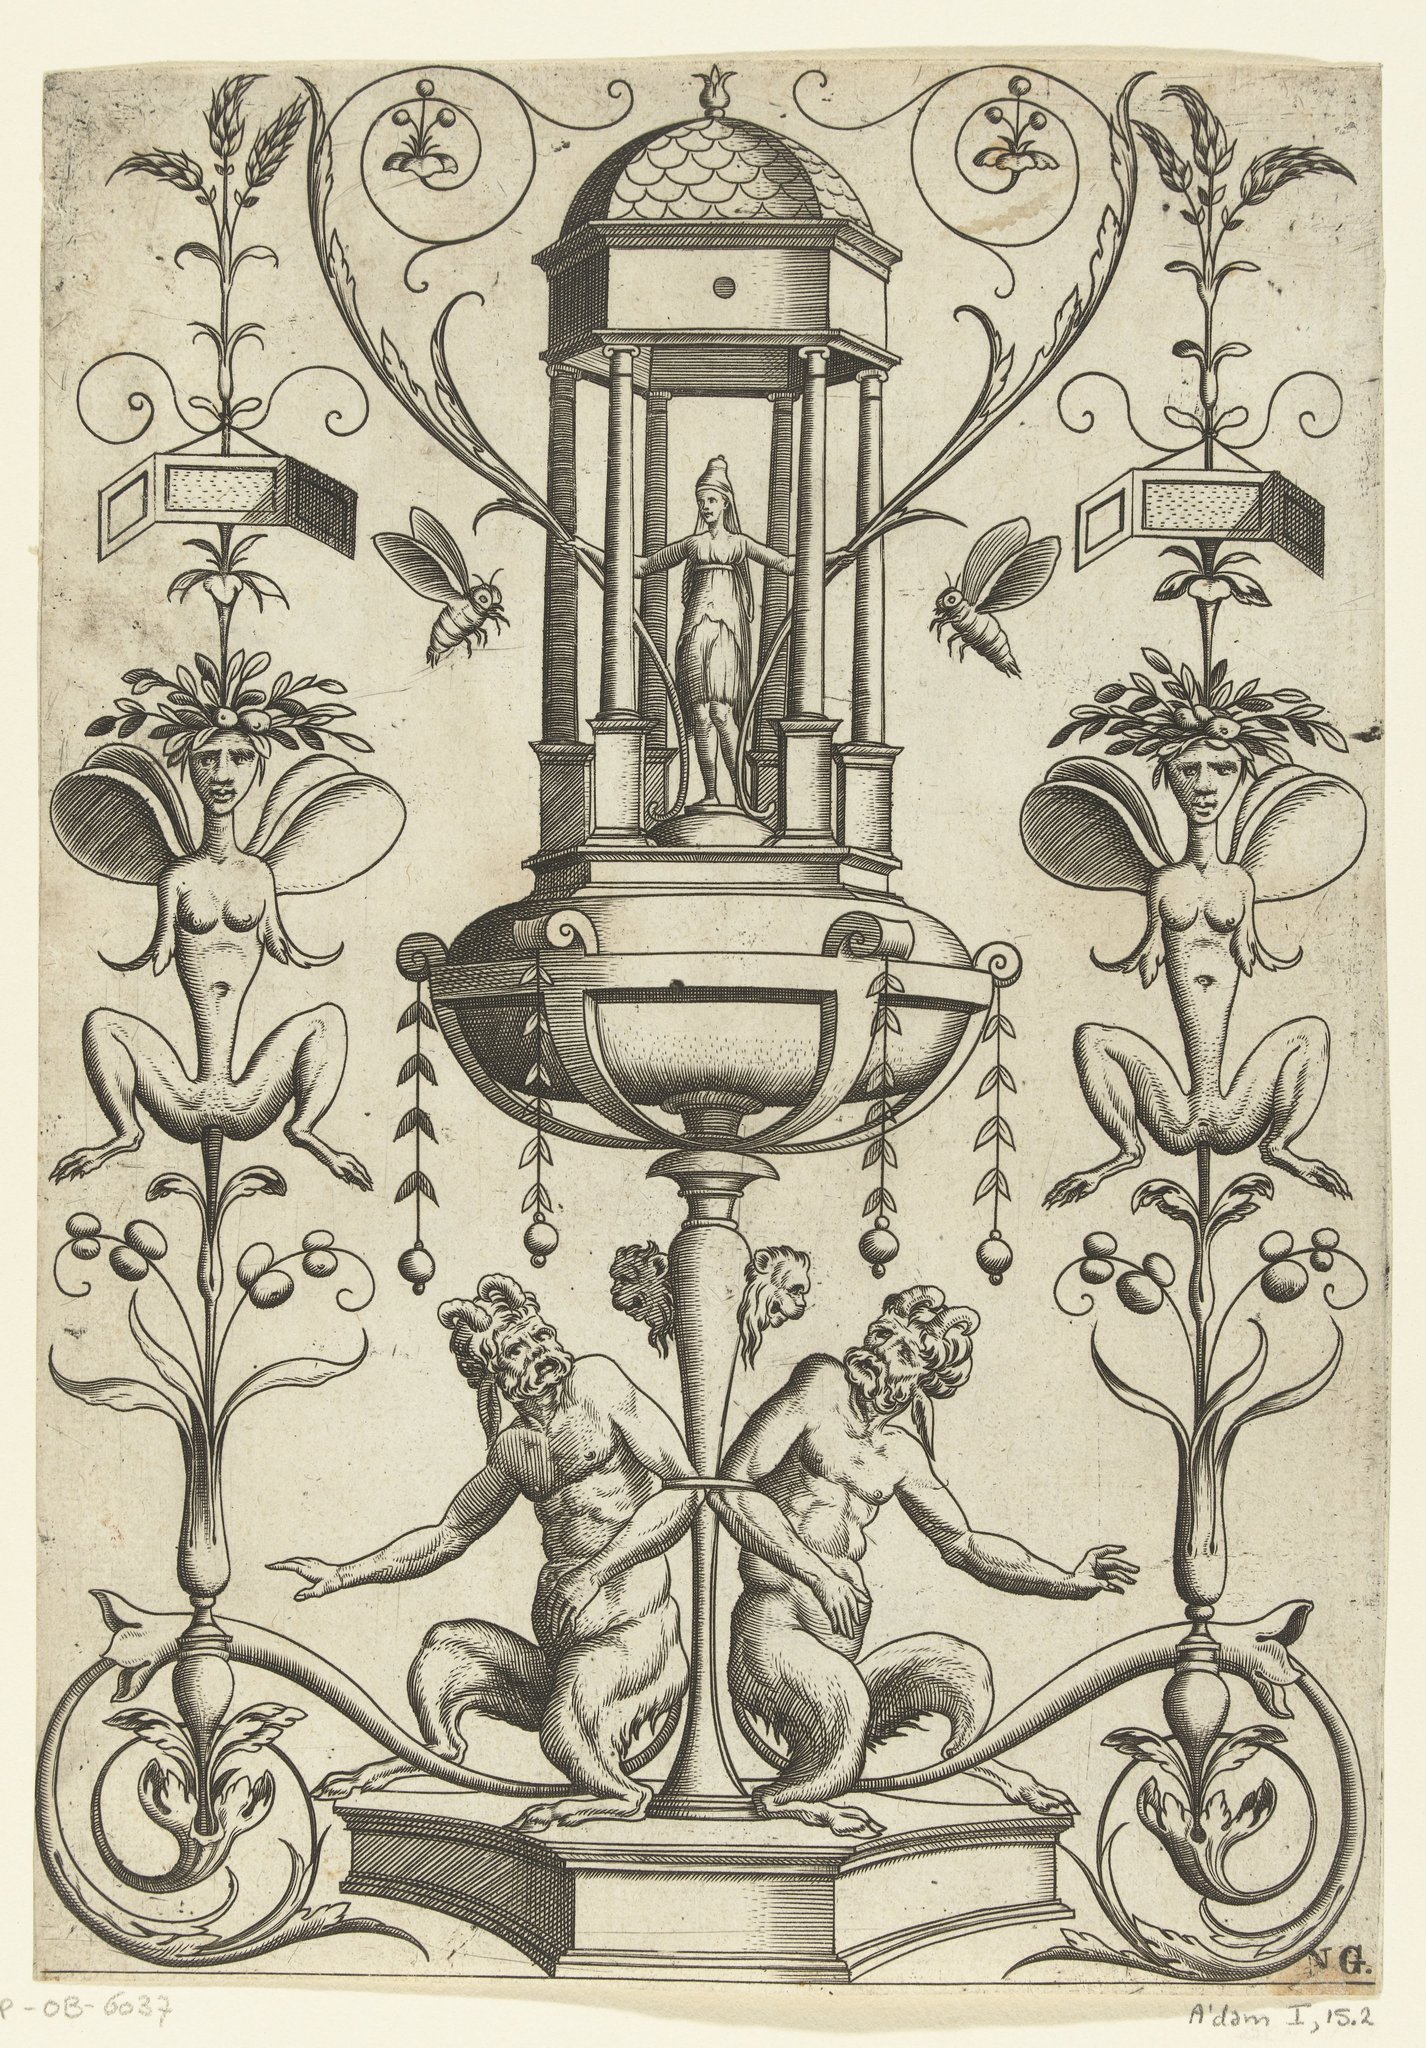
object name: ornament print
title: Groteske vlakdecoraties met kandelabers, mythologische figuren, fabelwezens, bladranken en trofeeën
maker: Anonymous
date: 1516-1556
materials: paper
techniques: engraving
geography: netherlands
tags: ornament ~ grotesque, cup, satyr(s) (in general)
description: Het deksel van de bokaal wordt gevormd door een tempeltje waar een vrouw in staat. Blad uit serie van 9 bladen.